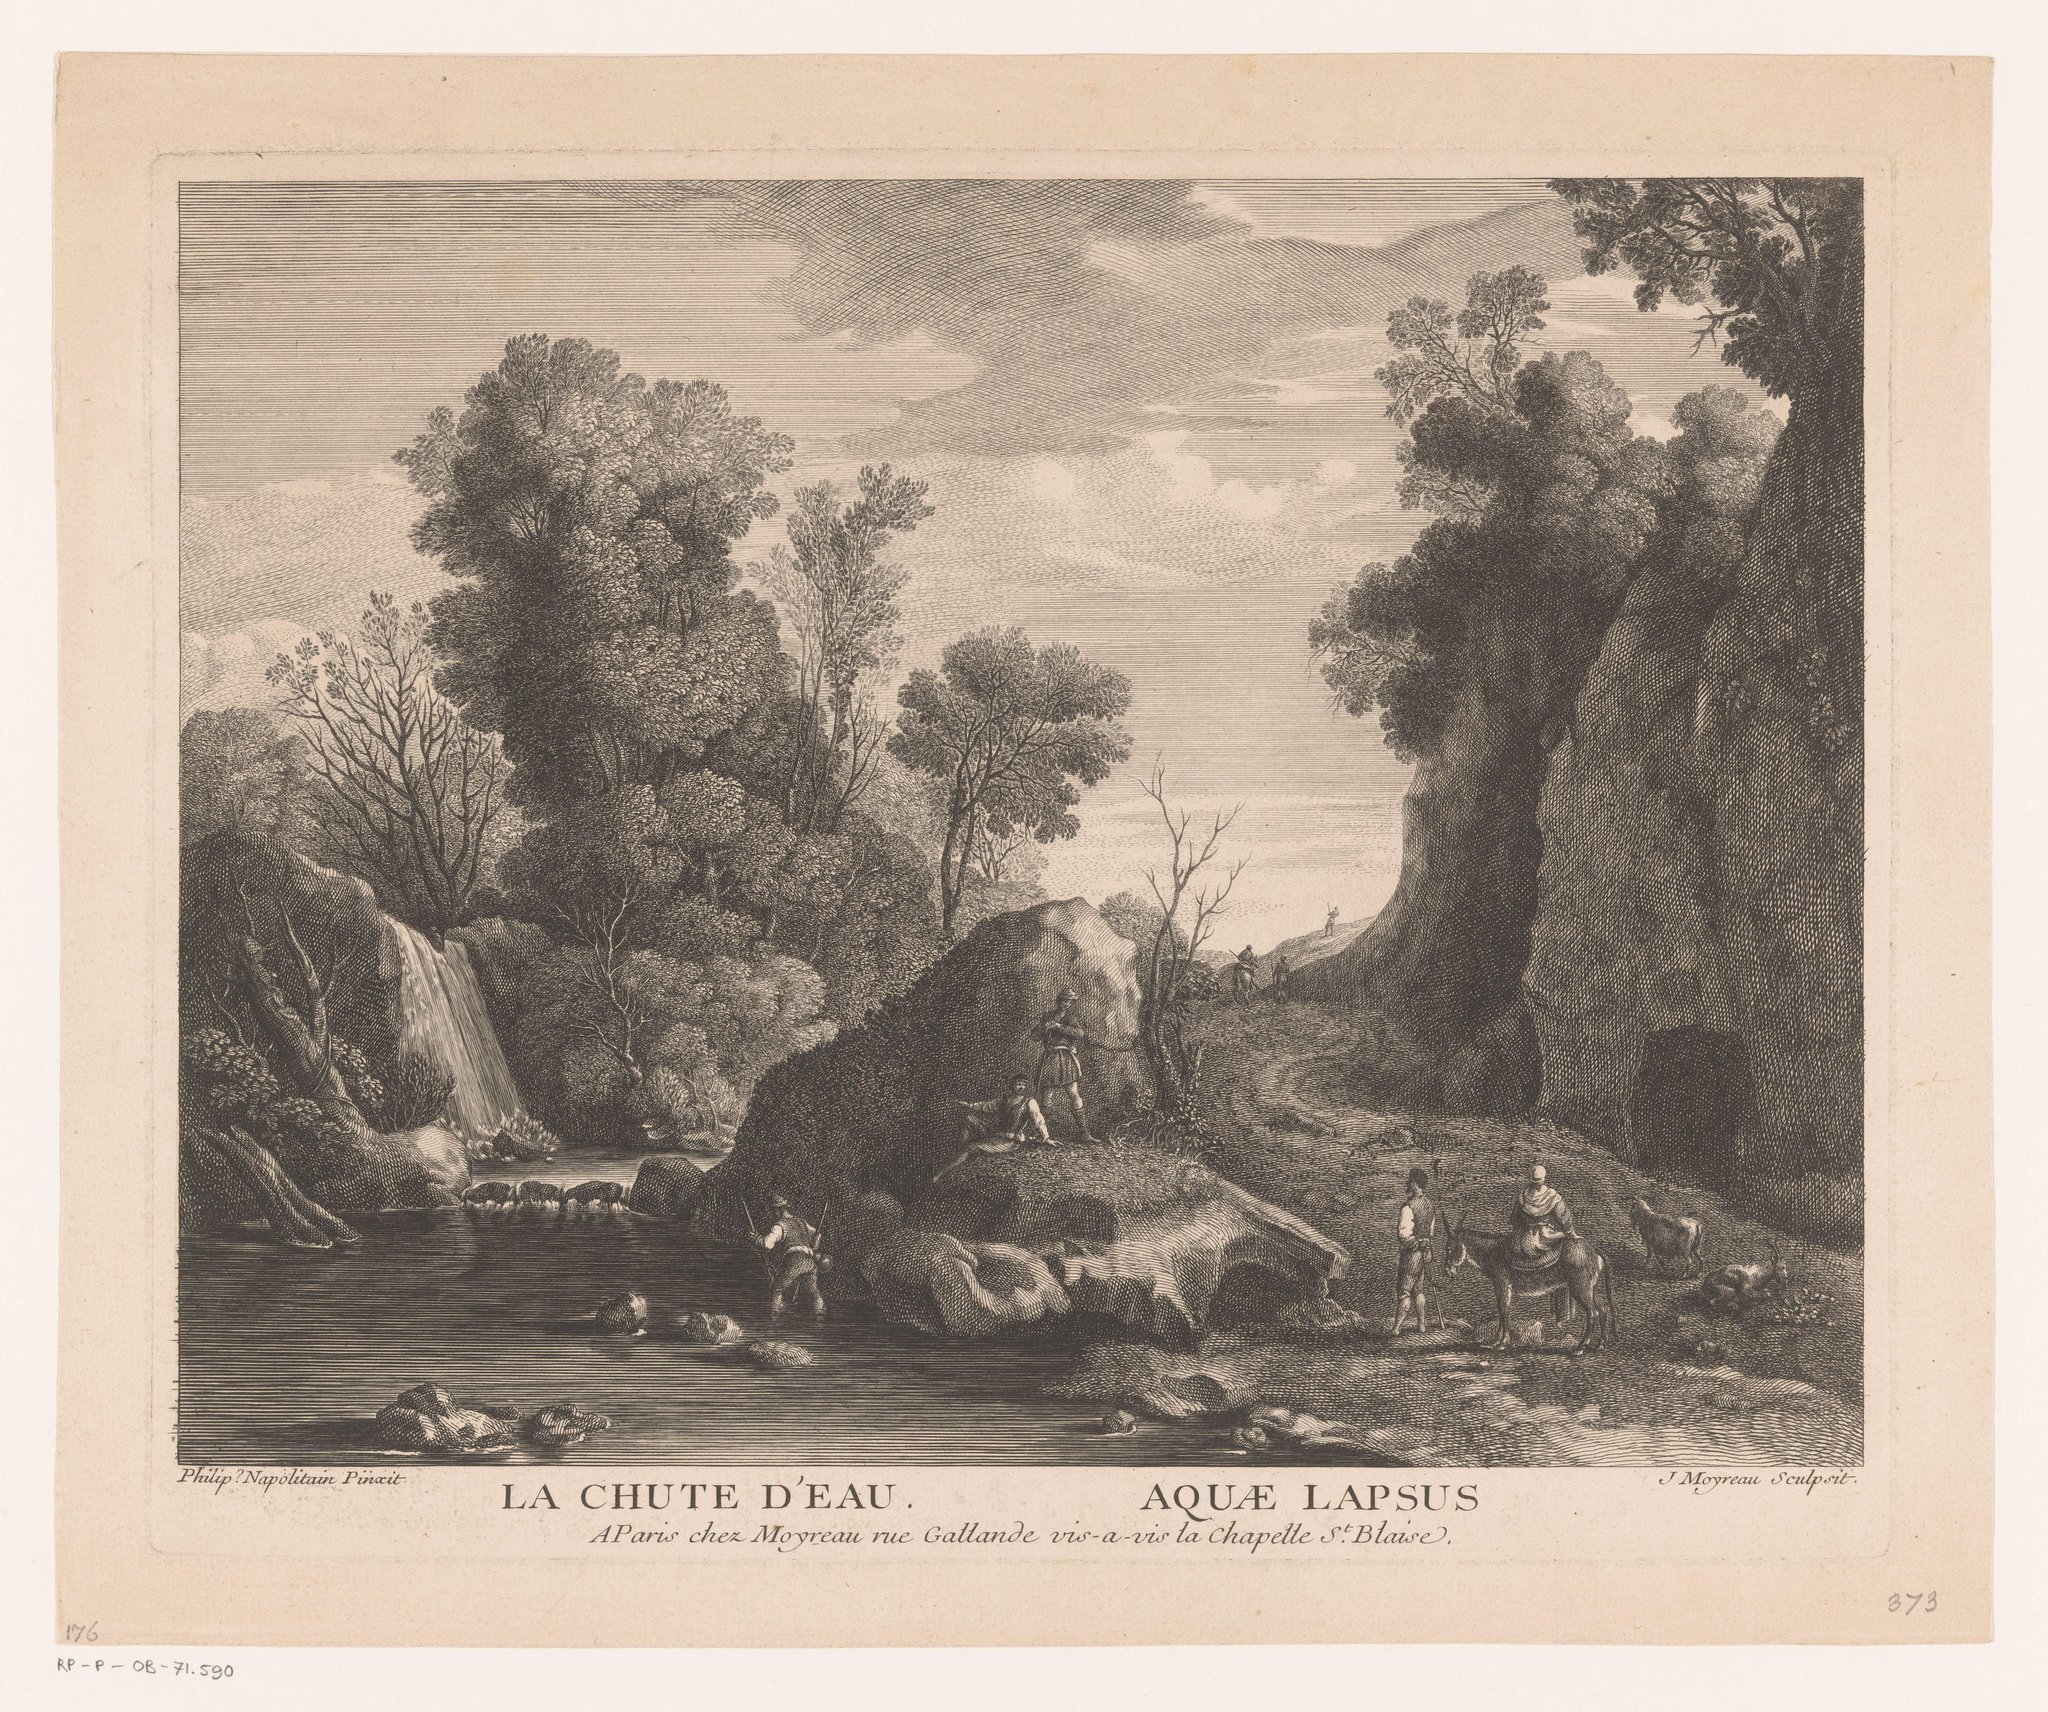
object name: print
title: La Chute d'Eau. Aquae Lapsus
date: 1700-1762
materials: paper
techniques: engraving, etching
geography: paris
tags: waterfall, landscapes in the temperate zone (+ landscape with figures, staffage)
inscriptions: watermark, collector's mark: Lugt 240